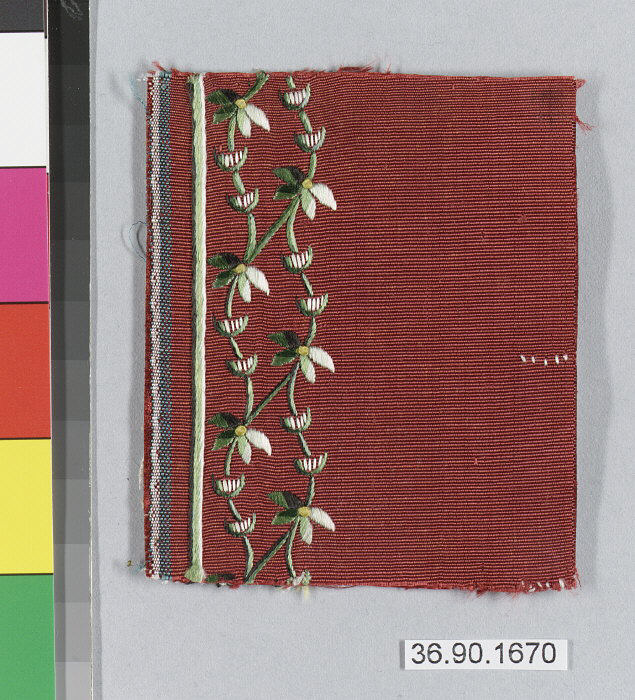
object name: sample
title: Embroidery sample for a man’s suit or waistcoat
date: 1785-1815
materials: silk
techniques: embroidery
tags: flowers